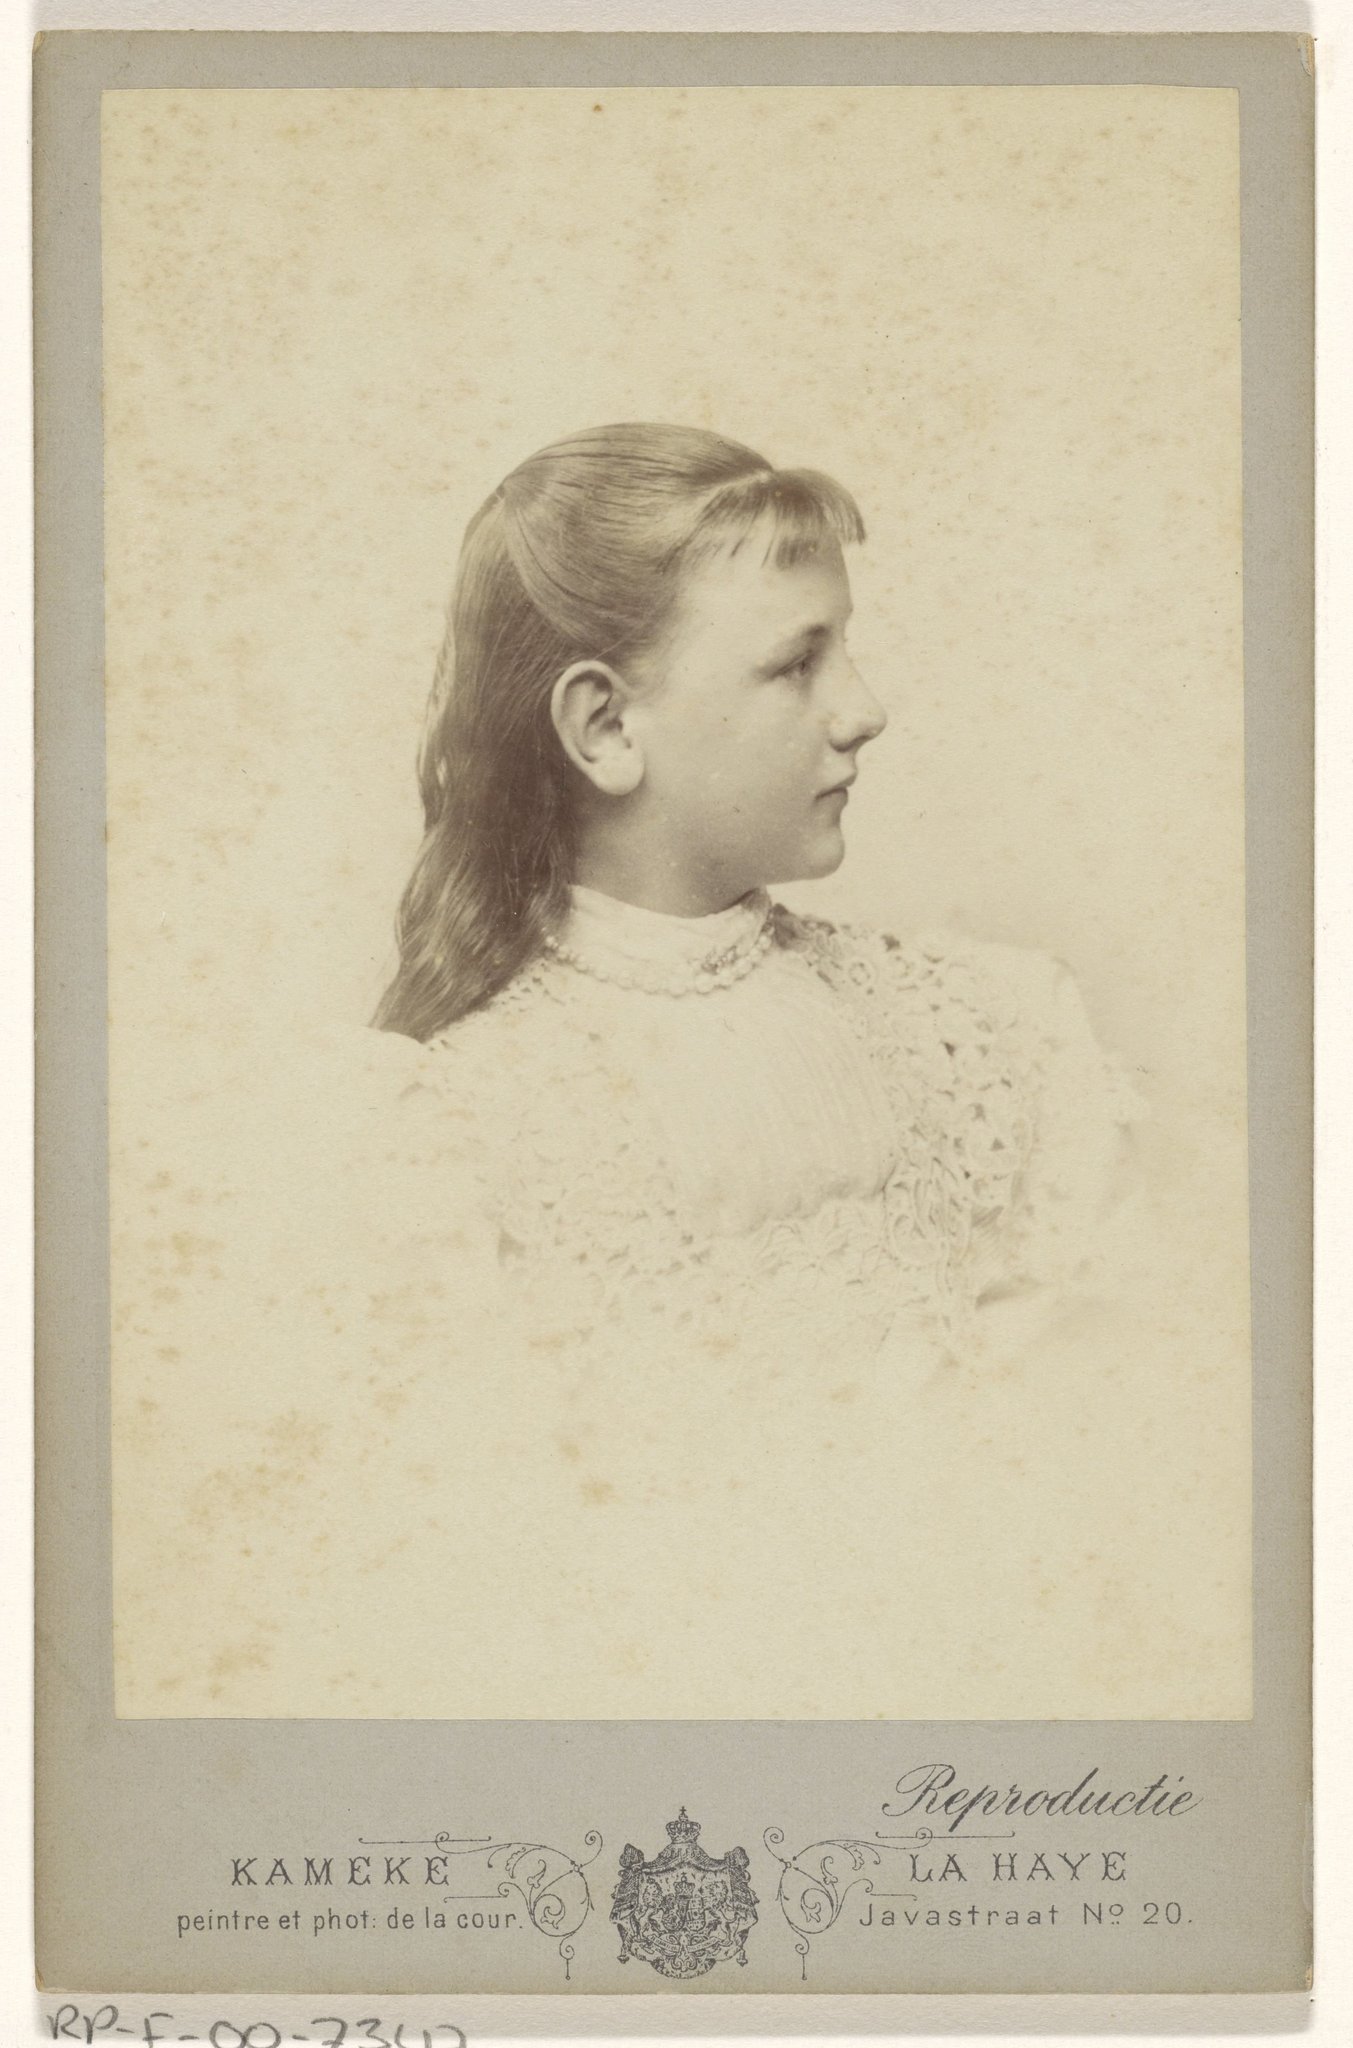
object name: photograph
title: Portret van Wilhelmina, koningin der Nederlanden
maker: richard kameke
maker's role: fotograaf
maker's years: 1847-1898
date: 1890-1895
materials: cardboard, paper, photographic support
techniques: albumen print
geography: the hague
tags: print maker, wilhelmina of the netherlands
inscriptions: address: ‘KAMEKE peintre et phot: de la cour LA HAYE Javastraat No: 20.’, address: ‘LIBRAIRIE ARTISTIQUE fondée 1813 A. van HOOGSTRATEN et FILS Fournisseurs de la Cour PLAATS 11 - LA HAYE.’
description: De hier vermelde titel verwijst naar de hoogst verkregen titel van de geportretteerde, niet per se naar de titel die de geportretteerde op deze voorstelling draagt.